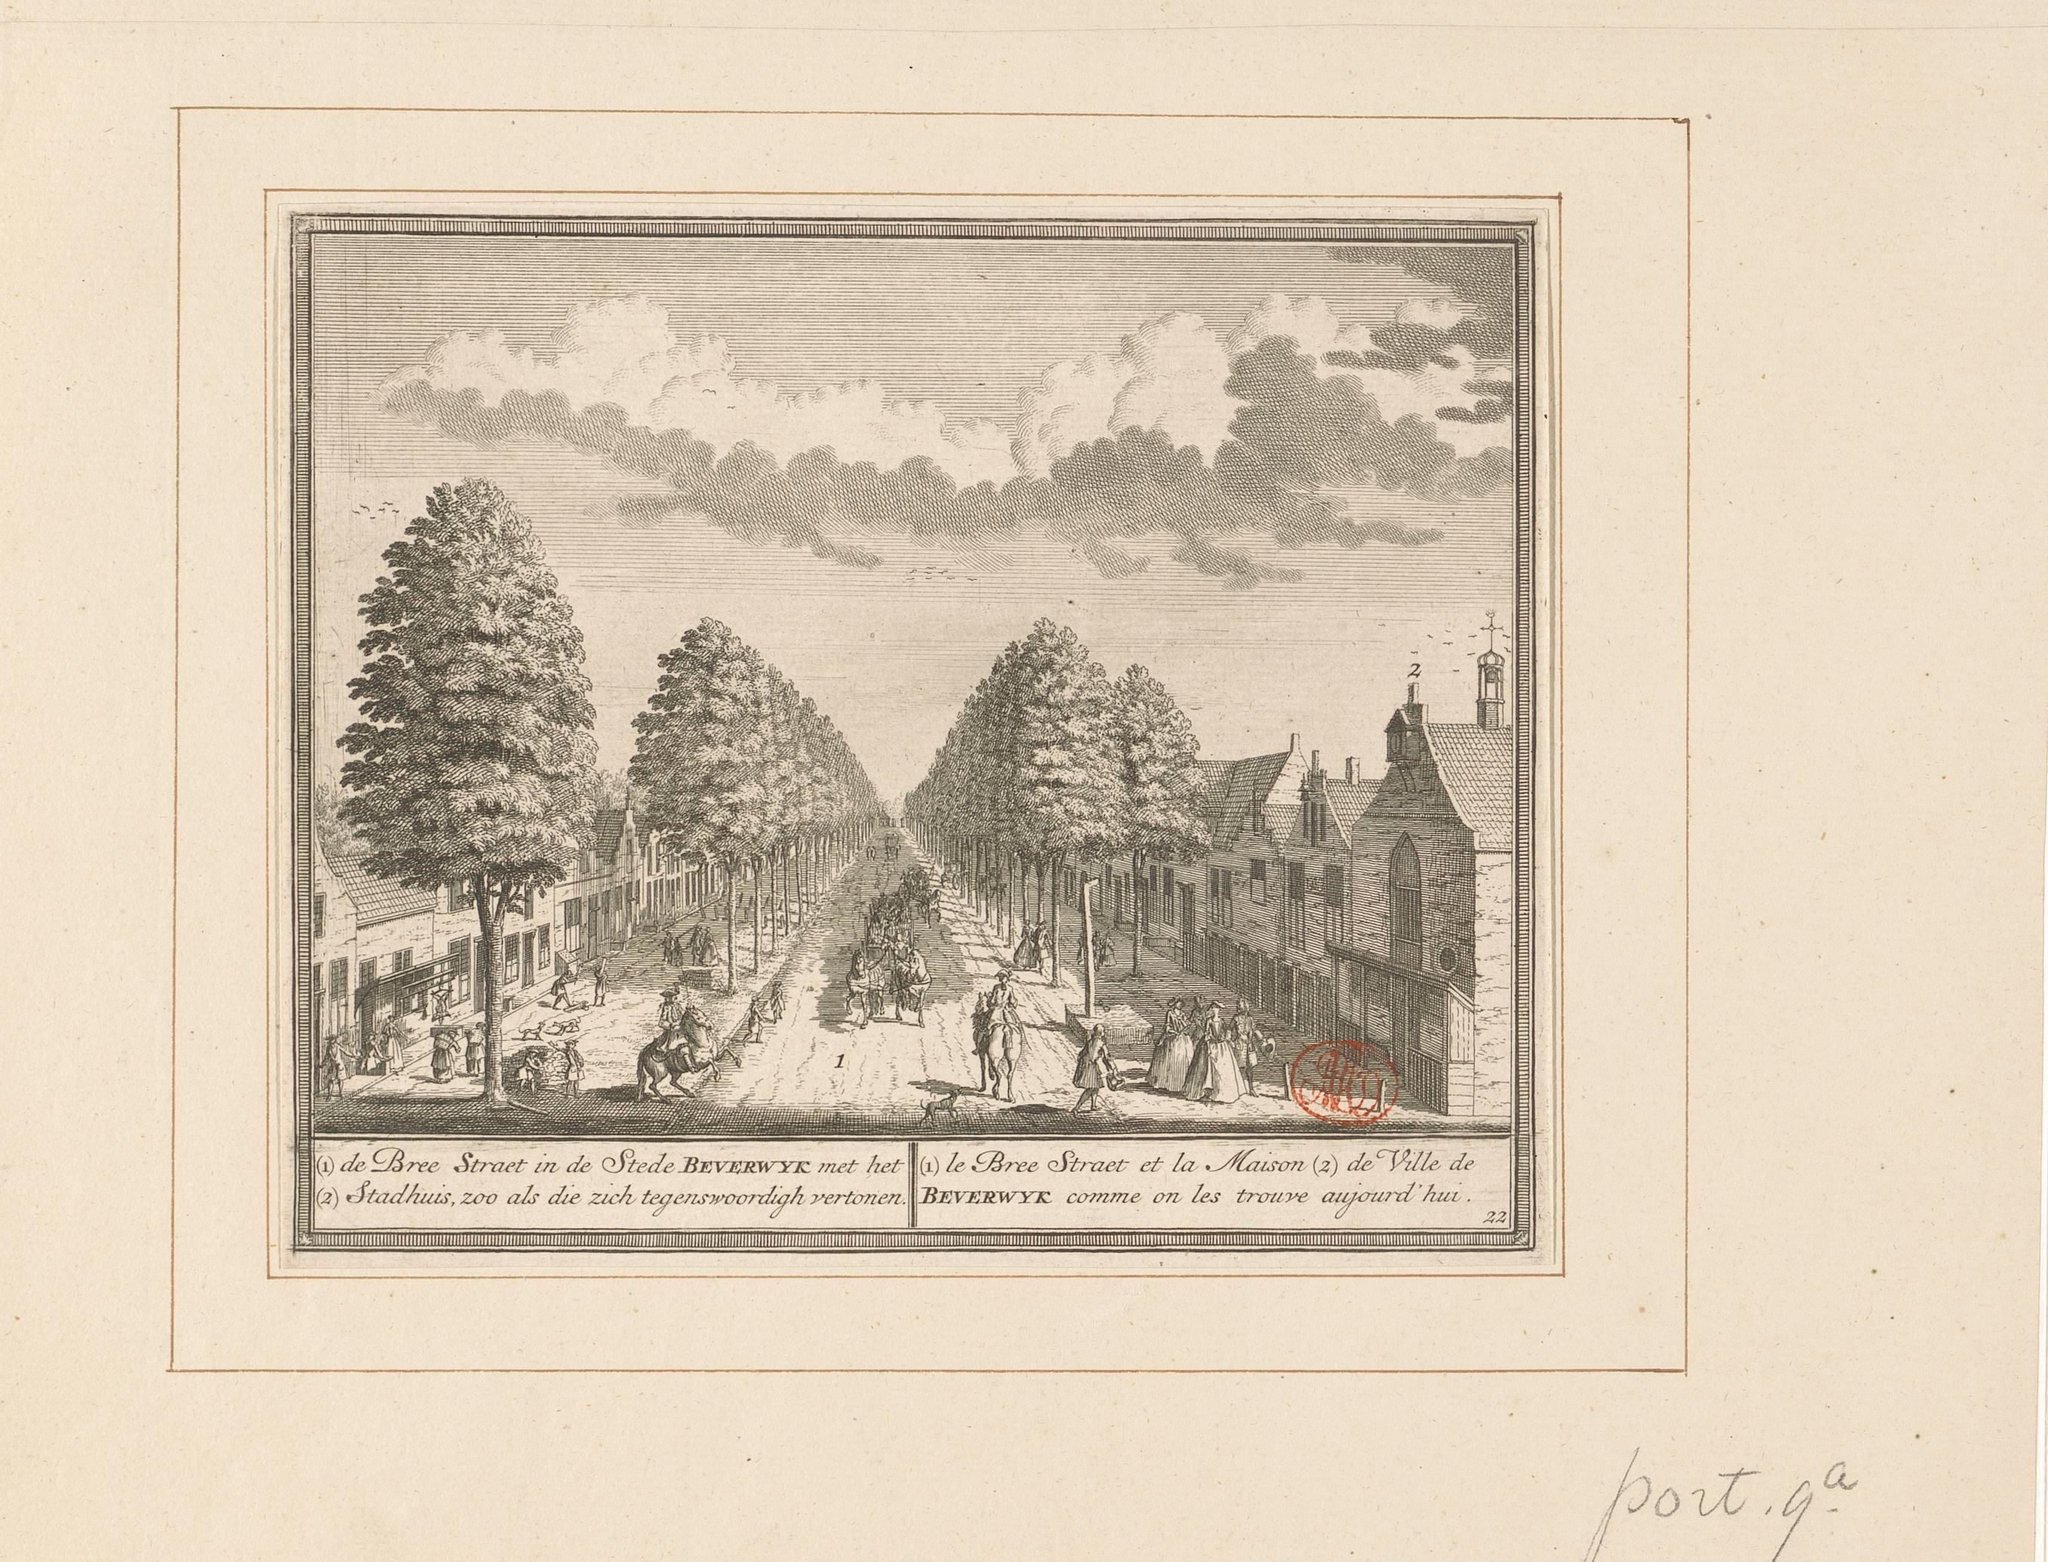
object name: book illustration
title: (1) de Bree Straet in de stede Beverwyk met het (2) stadhuis, zoo als die zich tegenswoordigh vertonen / (1) le Bree Straet et la maison (2) de ville de Beverwyk comme on les trouve aujourd'hui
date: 1729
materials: paper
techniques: etching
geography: amsterdam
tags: townhall, street (+ city(-scape) with figures, staffage)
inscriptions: collector's mark: Lugt 195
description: Prent ook gebruikt in: Brouërius van Nidek, Matthaeus. Het zegenpralent Kennemerlant, vertoont in (…). 2 delen. Amsterdam: Andries en Hendrik de Leth, 1729-1732, deel 1 (1729).